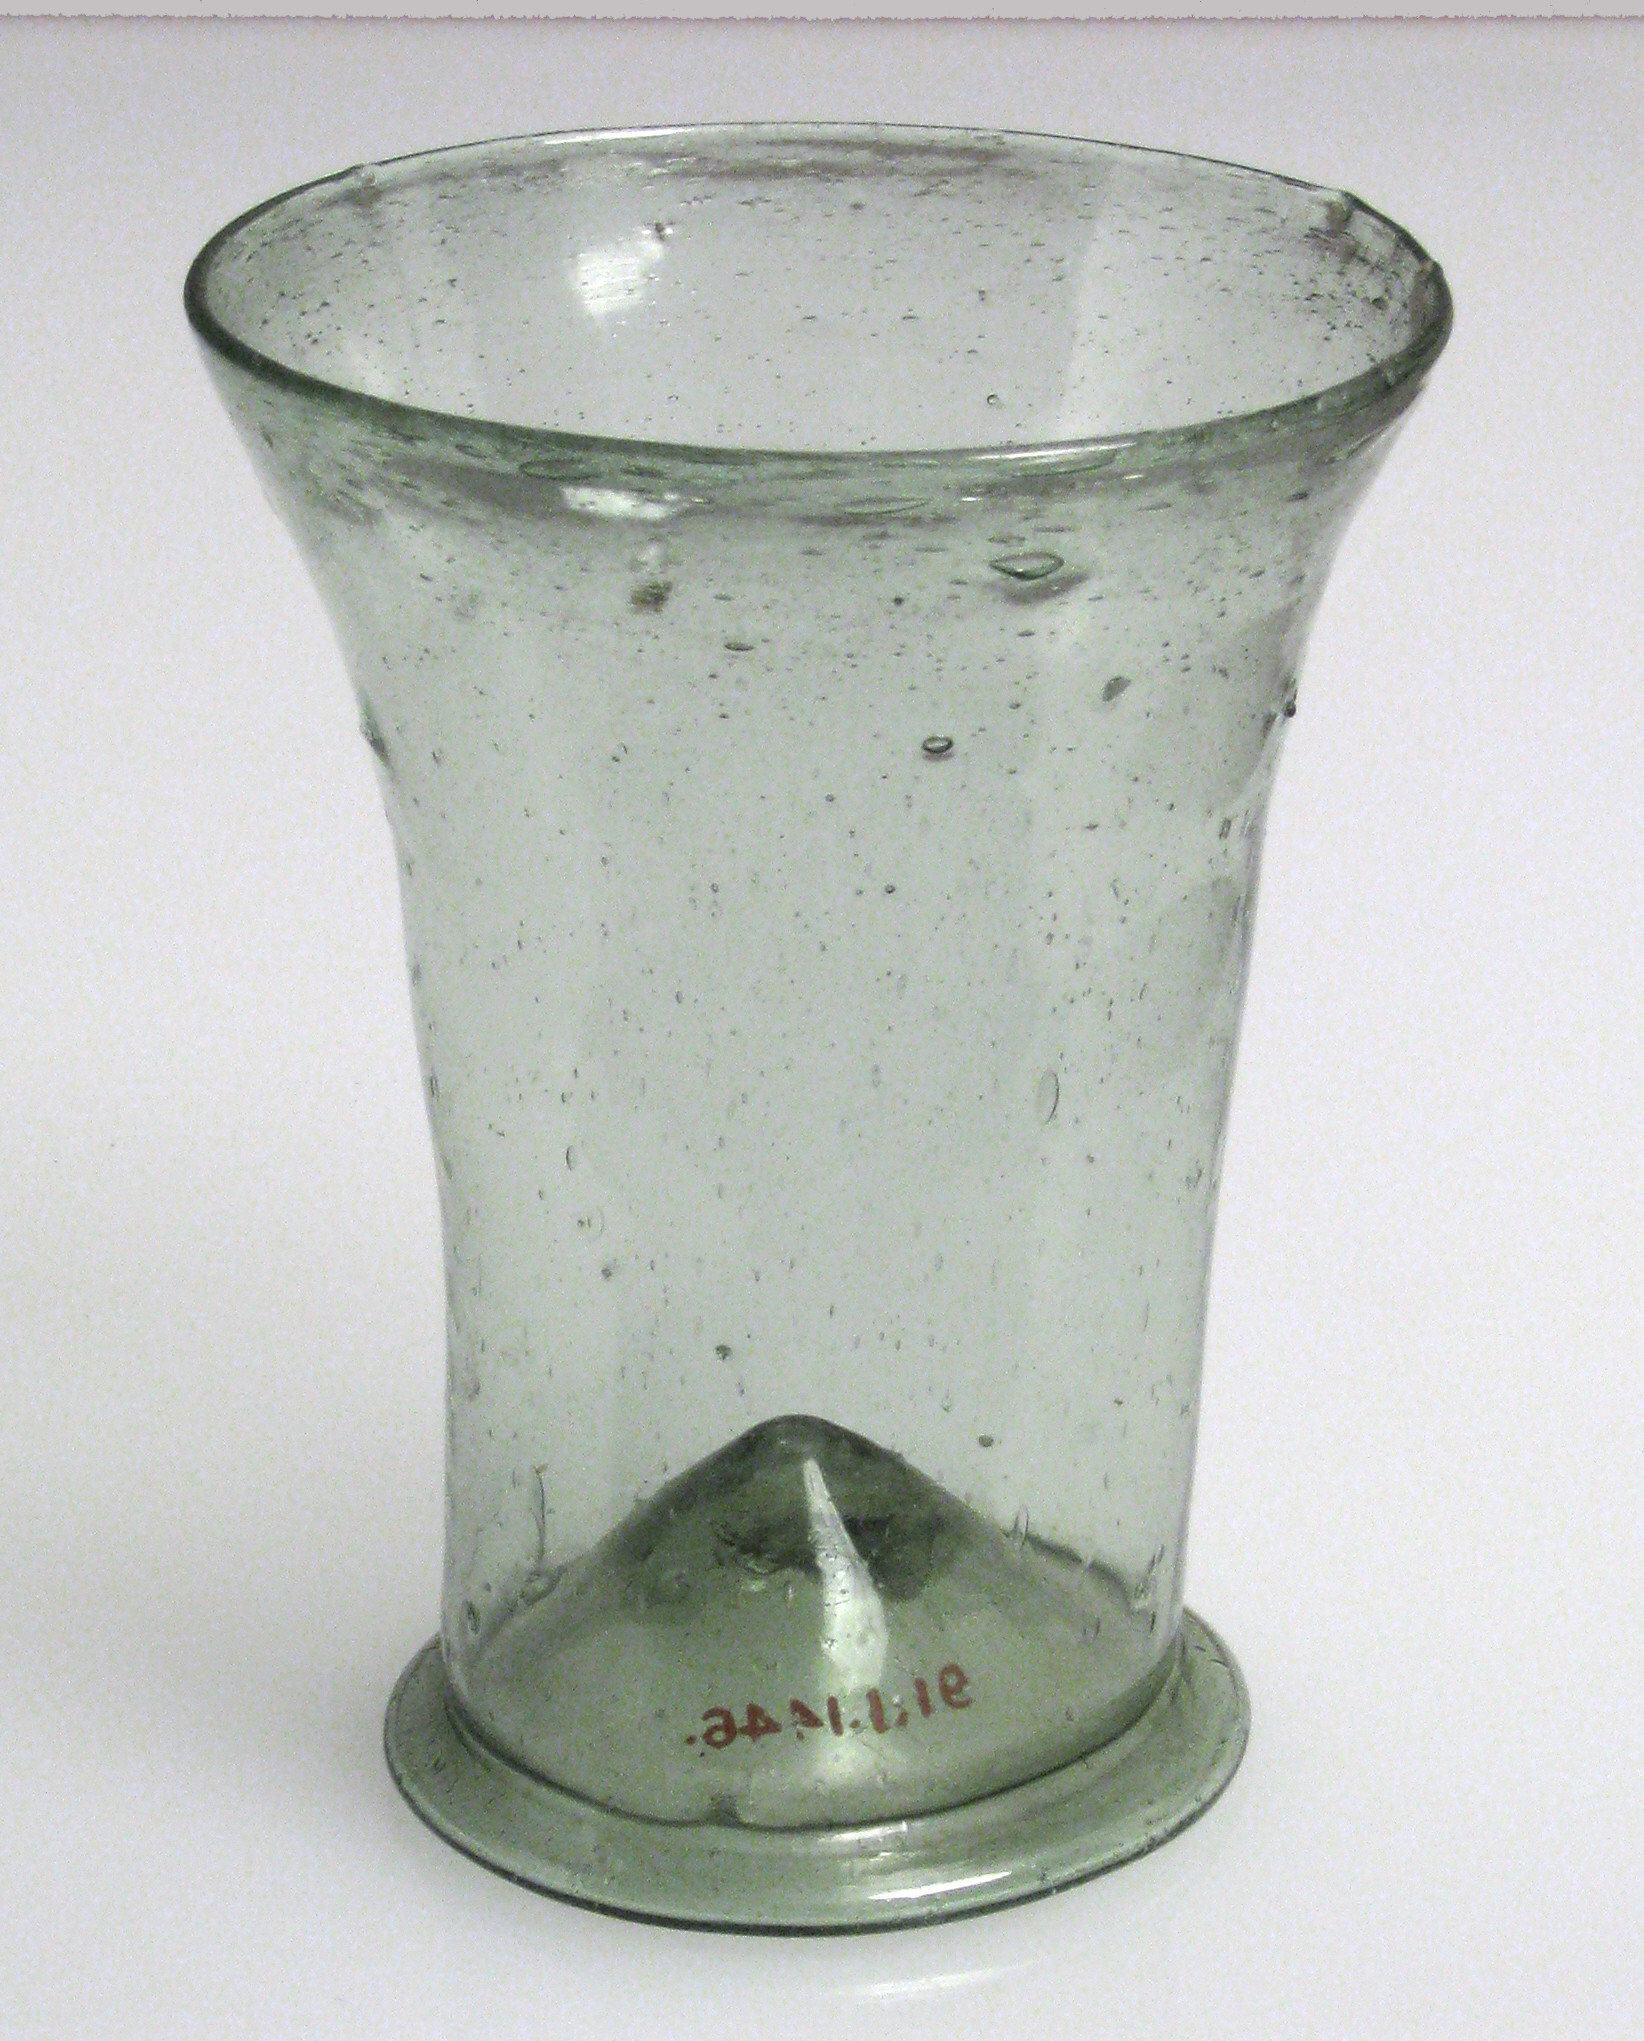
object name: beaker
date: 1501-1600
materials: glass